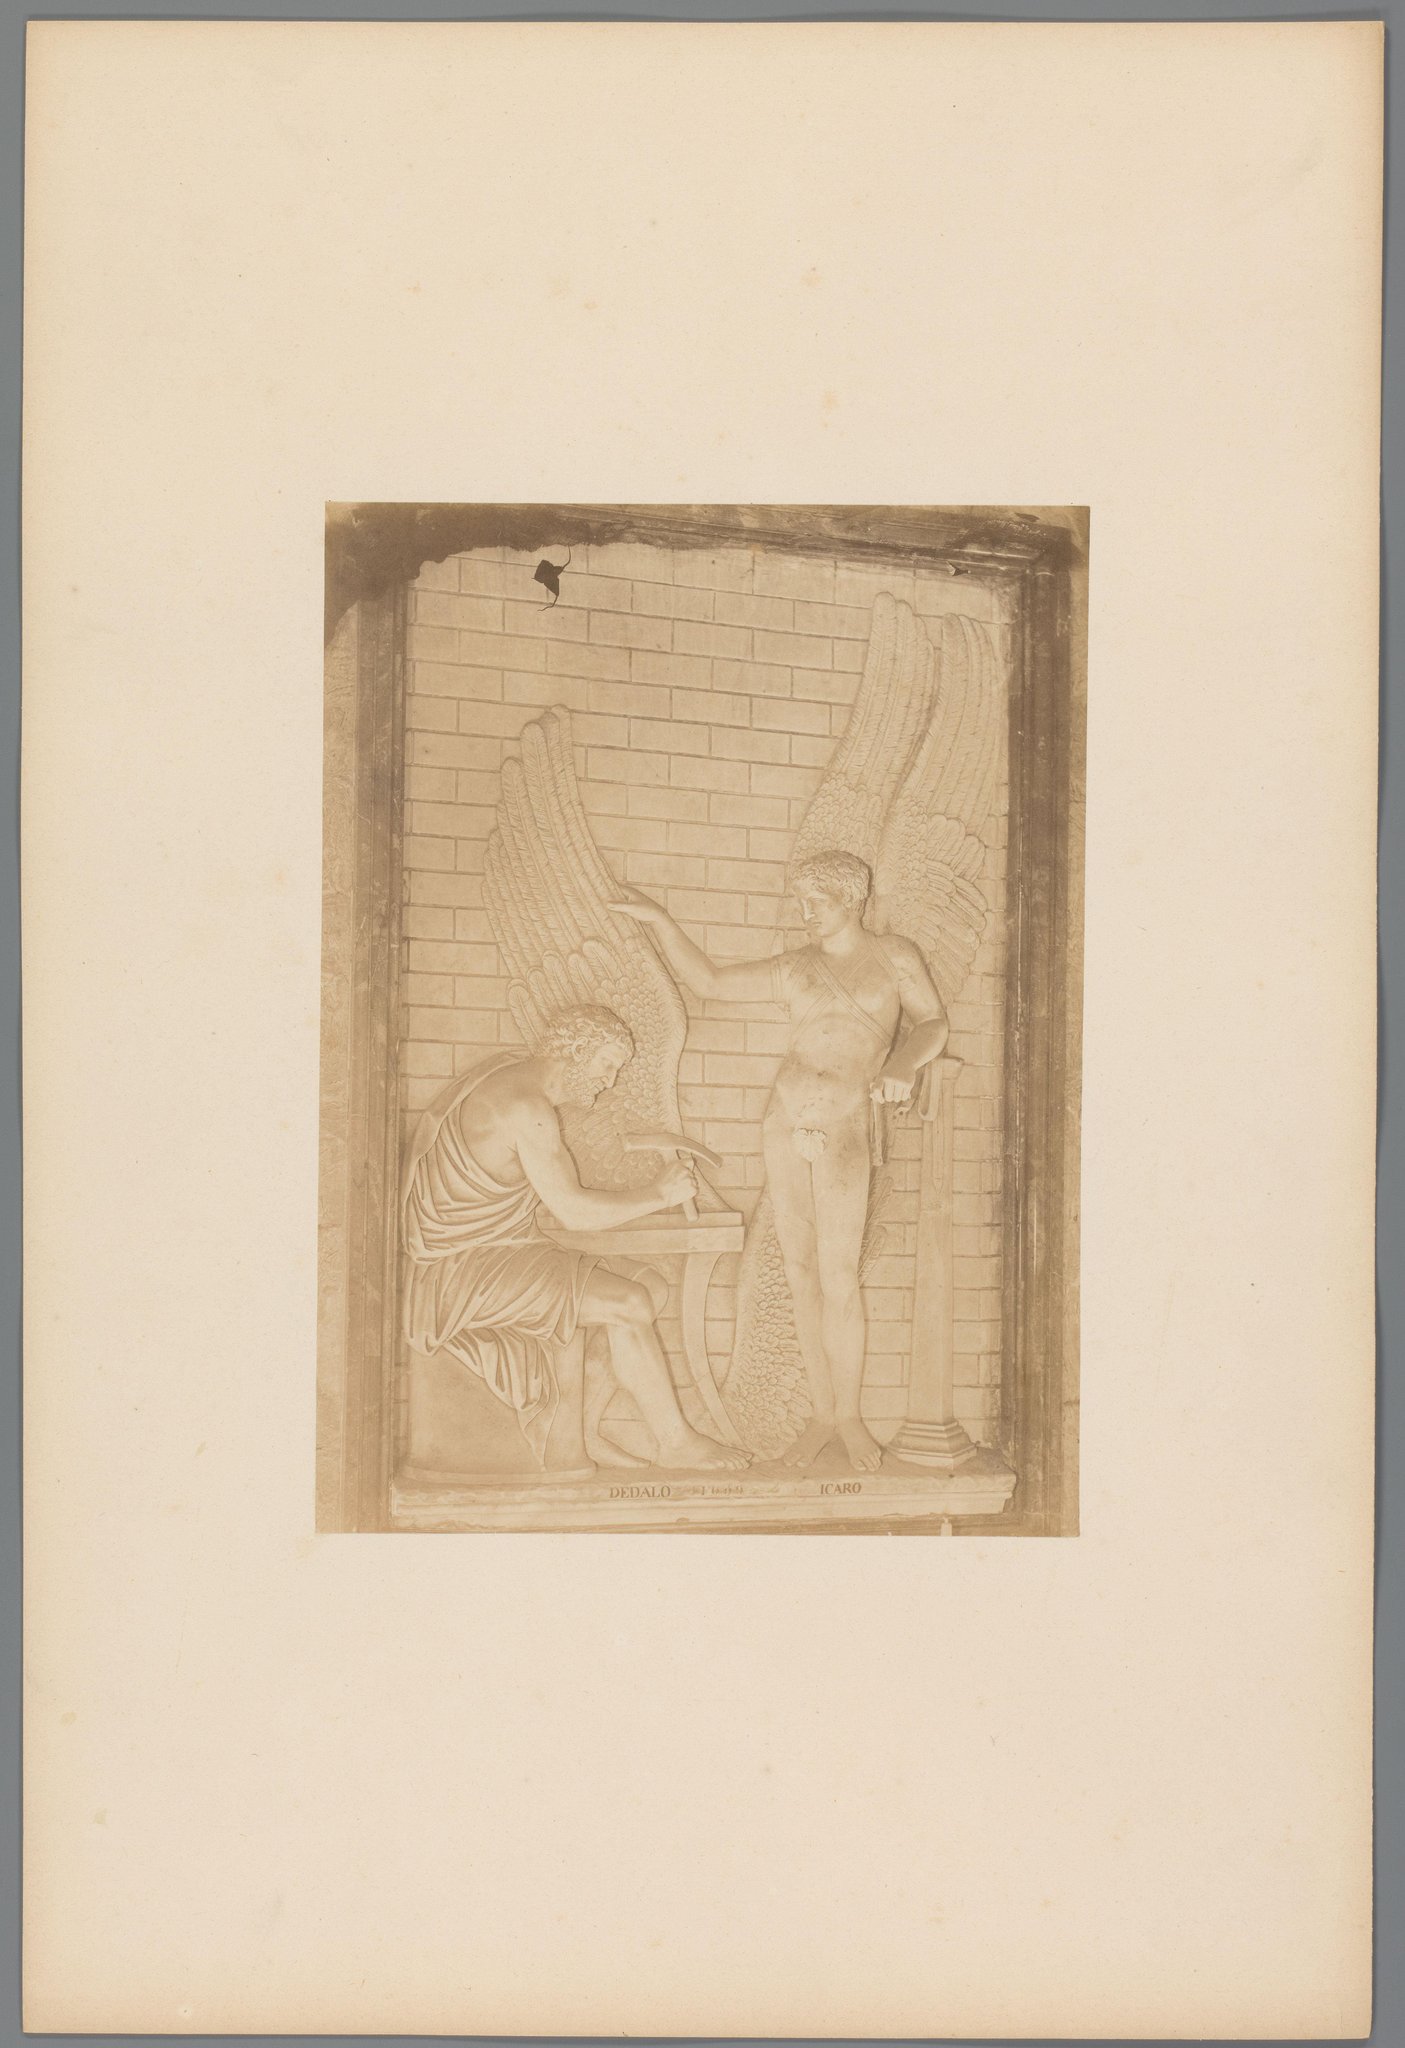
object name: photograph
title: Reliëf van Daedelus die de vleugels van Icarus maakt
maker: Anonymous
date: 1851-1900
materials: cardboard, paper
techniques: albumen print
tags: daedalus makes the wings while icarus looks on, art (+ relief ~ sculpture)